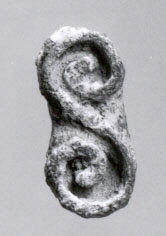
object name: stamp seal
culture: bactria-margiana archaeological complex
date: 2333-1668 BCE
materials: copper alloy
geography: bactria-margiana